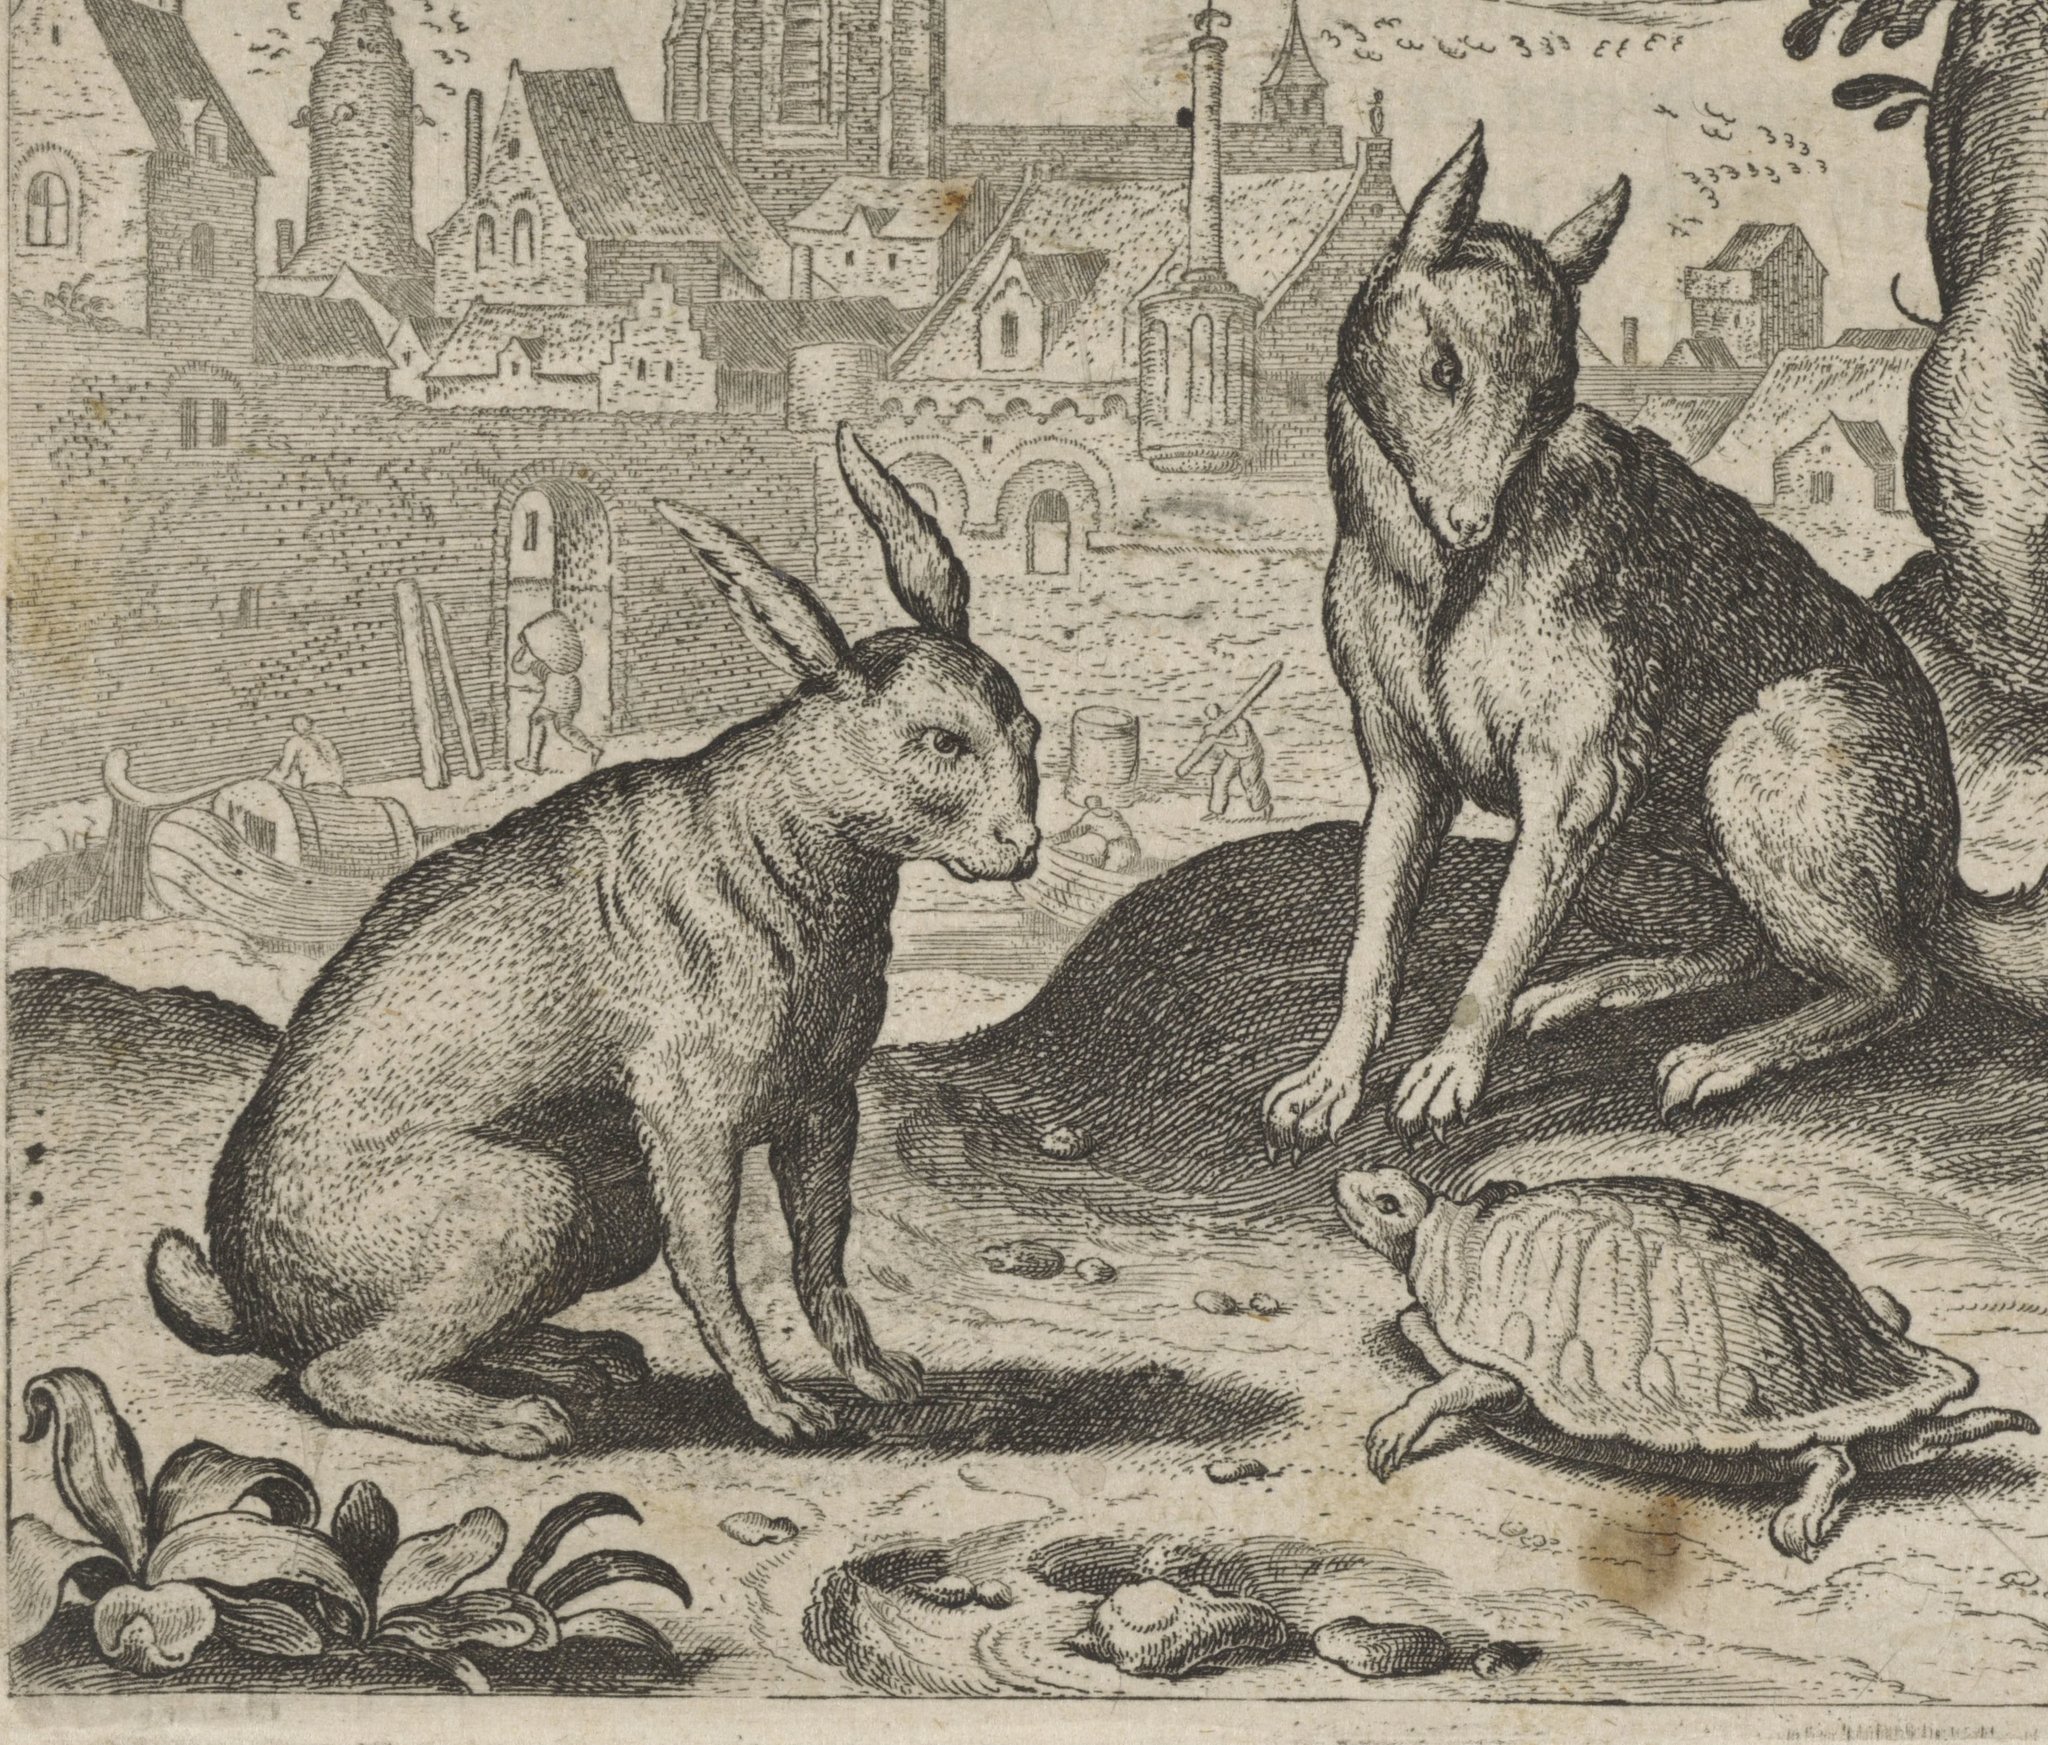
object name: book illustration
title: Fabel van de schildpad en de haas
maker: aegidius sadeler (ii)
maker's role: draughtsman, print maker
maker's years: 1568-1629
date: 1608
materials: paper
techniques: engraving, etching, letterpress printing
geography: prague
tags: tortoises, turtles, city-view in general; 'veduta', rodents: hare, fables, beasts of prey, predatory animals: fox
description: Een schildpad en een haas staan bij een vos. Op de achtergrond een stad. De fabel beschrijft de loopwedstrijd tussen de schildpad en de haas. De haas is veel sneller dan de schildpad. Hij waant zich al gewonnen en gaat rusten voordat hij de eindstreep heeft bereikt. De schildpad gaat traag vooruit maar heeft doorzettingsvermogen en komt als eerste over de streep. De moraal van het verhaal leert dat doorzettingsvermogen belangrijker is dan talent.